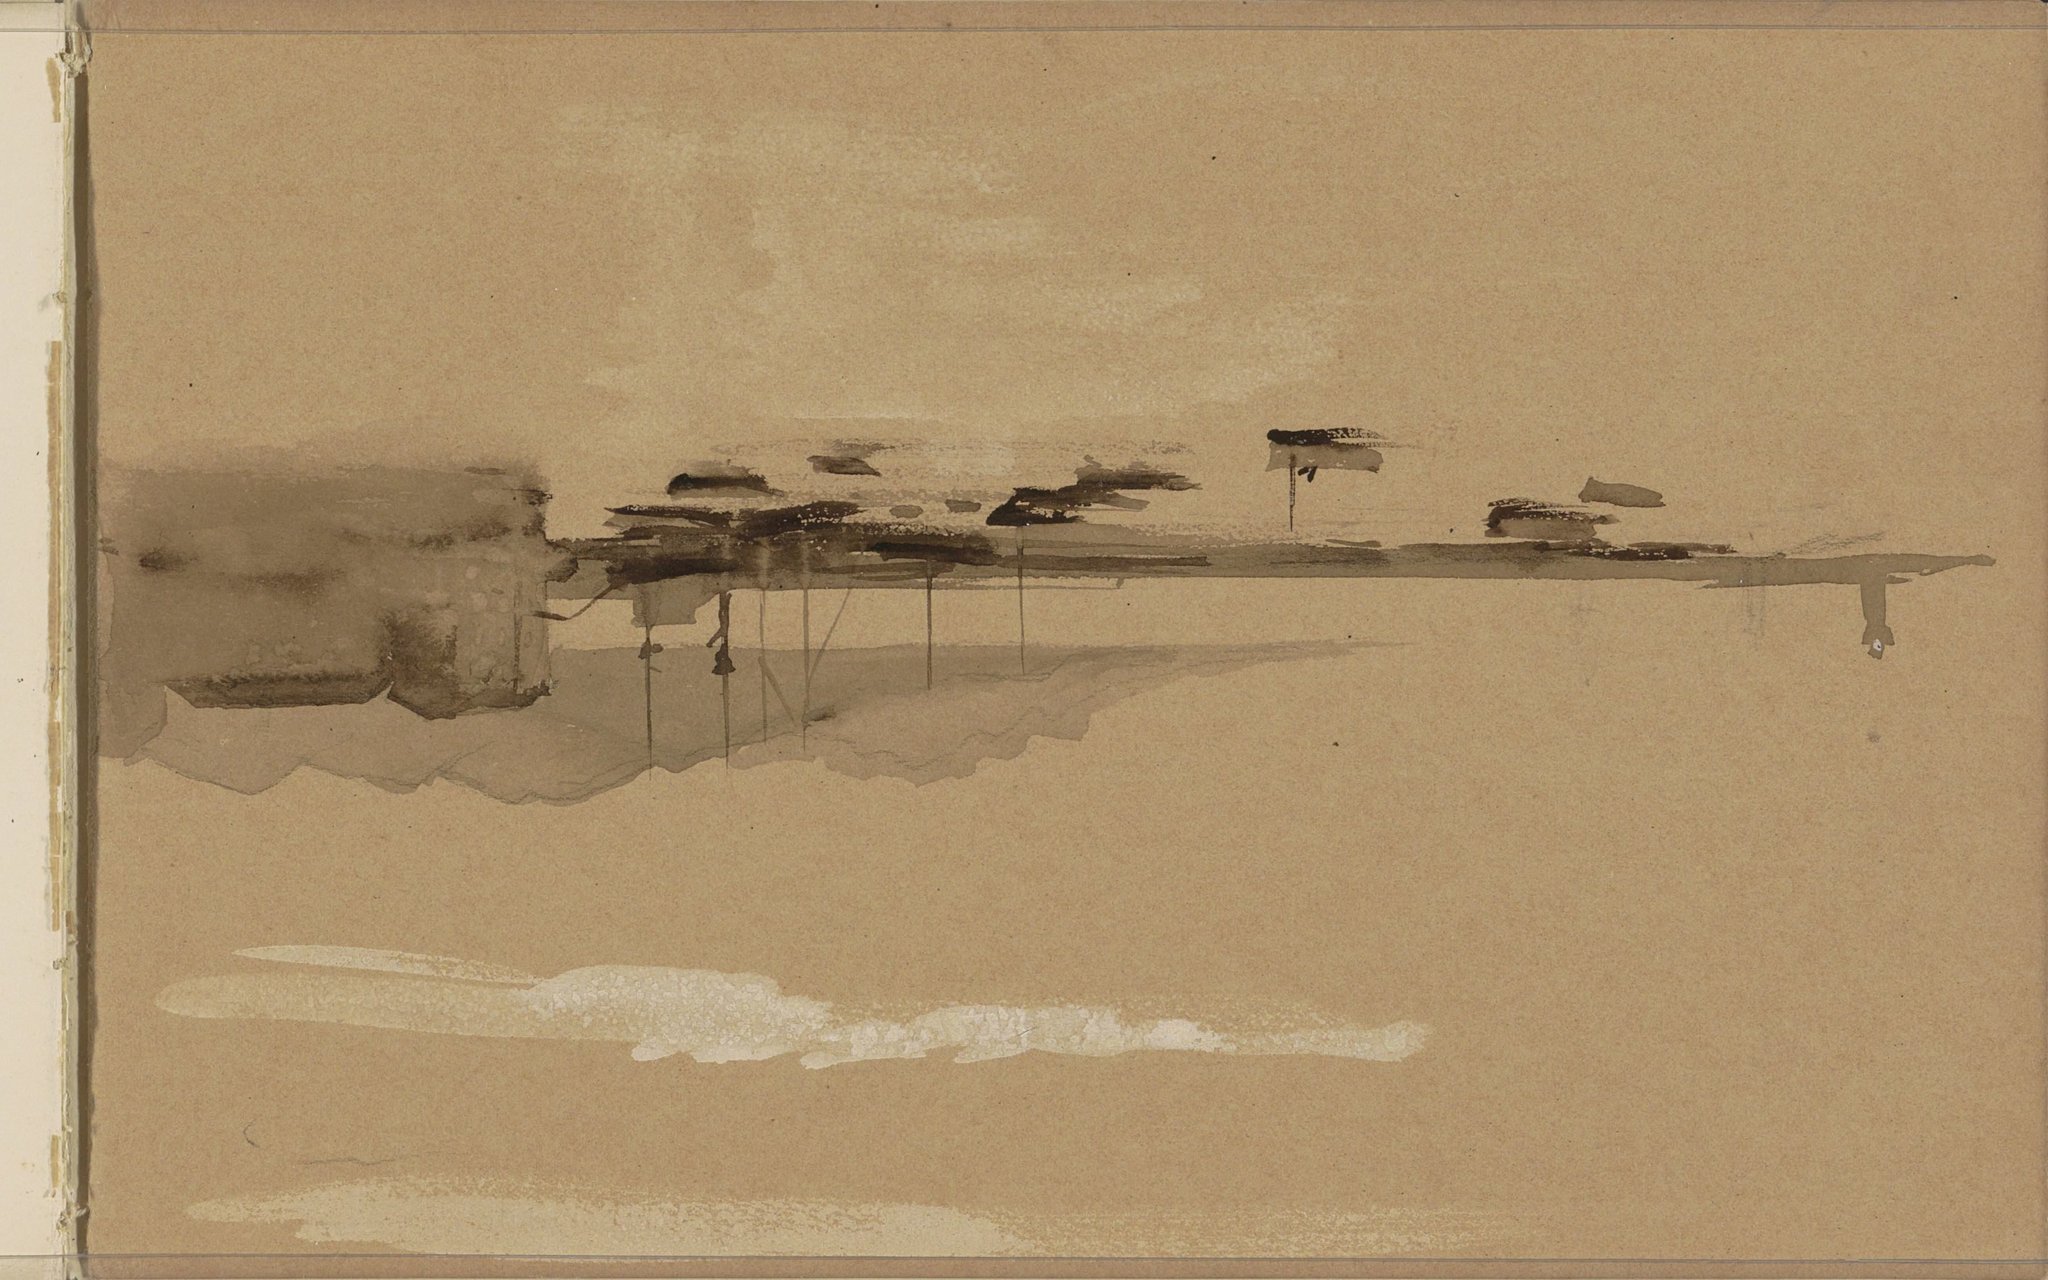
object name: sketchbook leaf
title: Zeilschepen bij een havenhoofd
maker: a.a.l. de grammont-hubrecht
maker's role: draughtsman, painter, print maker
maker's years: 1855-1913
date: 1865-1913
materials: paper, pencil, watercolor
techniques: brush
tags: sailing-ship, sailing-boat, landscapes with waters, waterscapes, seascapes (in the temperate zone), pier, quay, wharf, mountains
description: Op de achtergrond bergen. Blad 55 recto uit een schetsboek met 65 bladen.